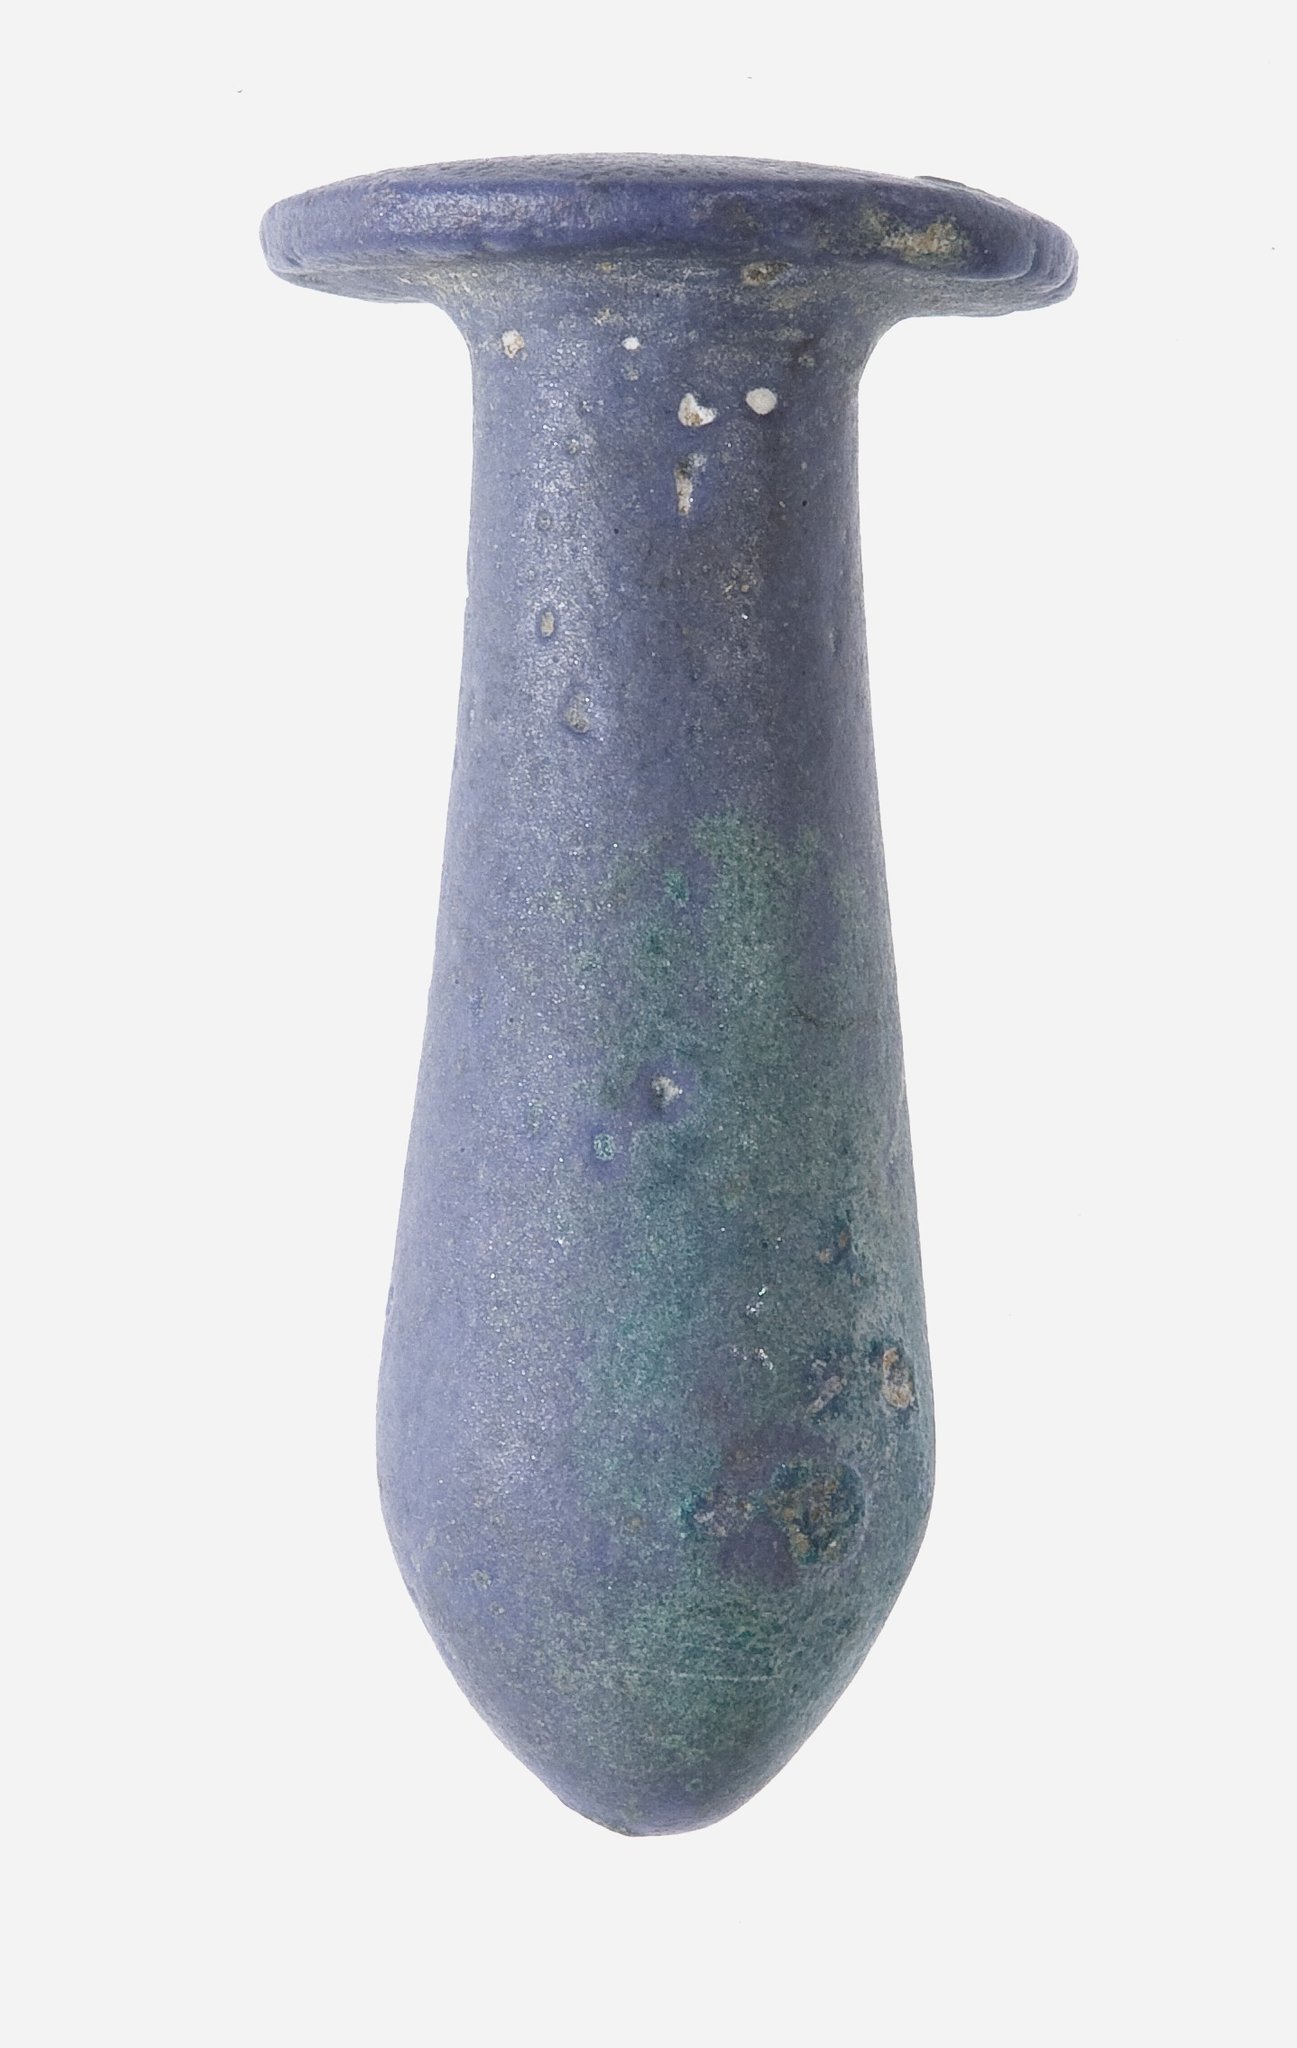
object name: ear stud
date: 1390-1352 BCE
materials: faience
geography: egypt